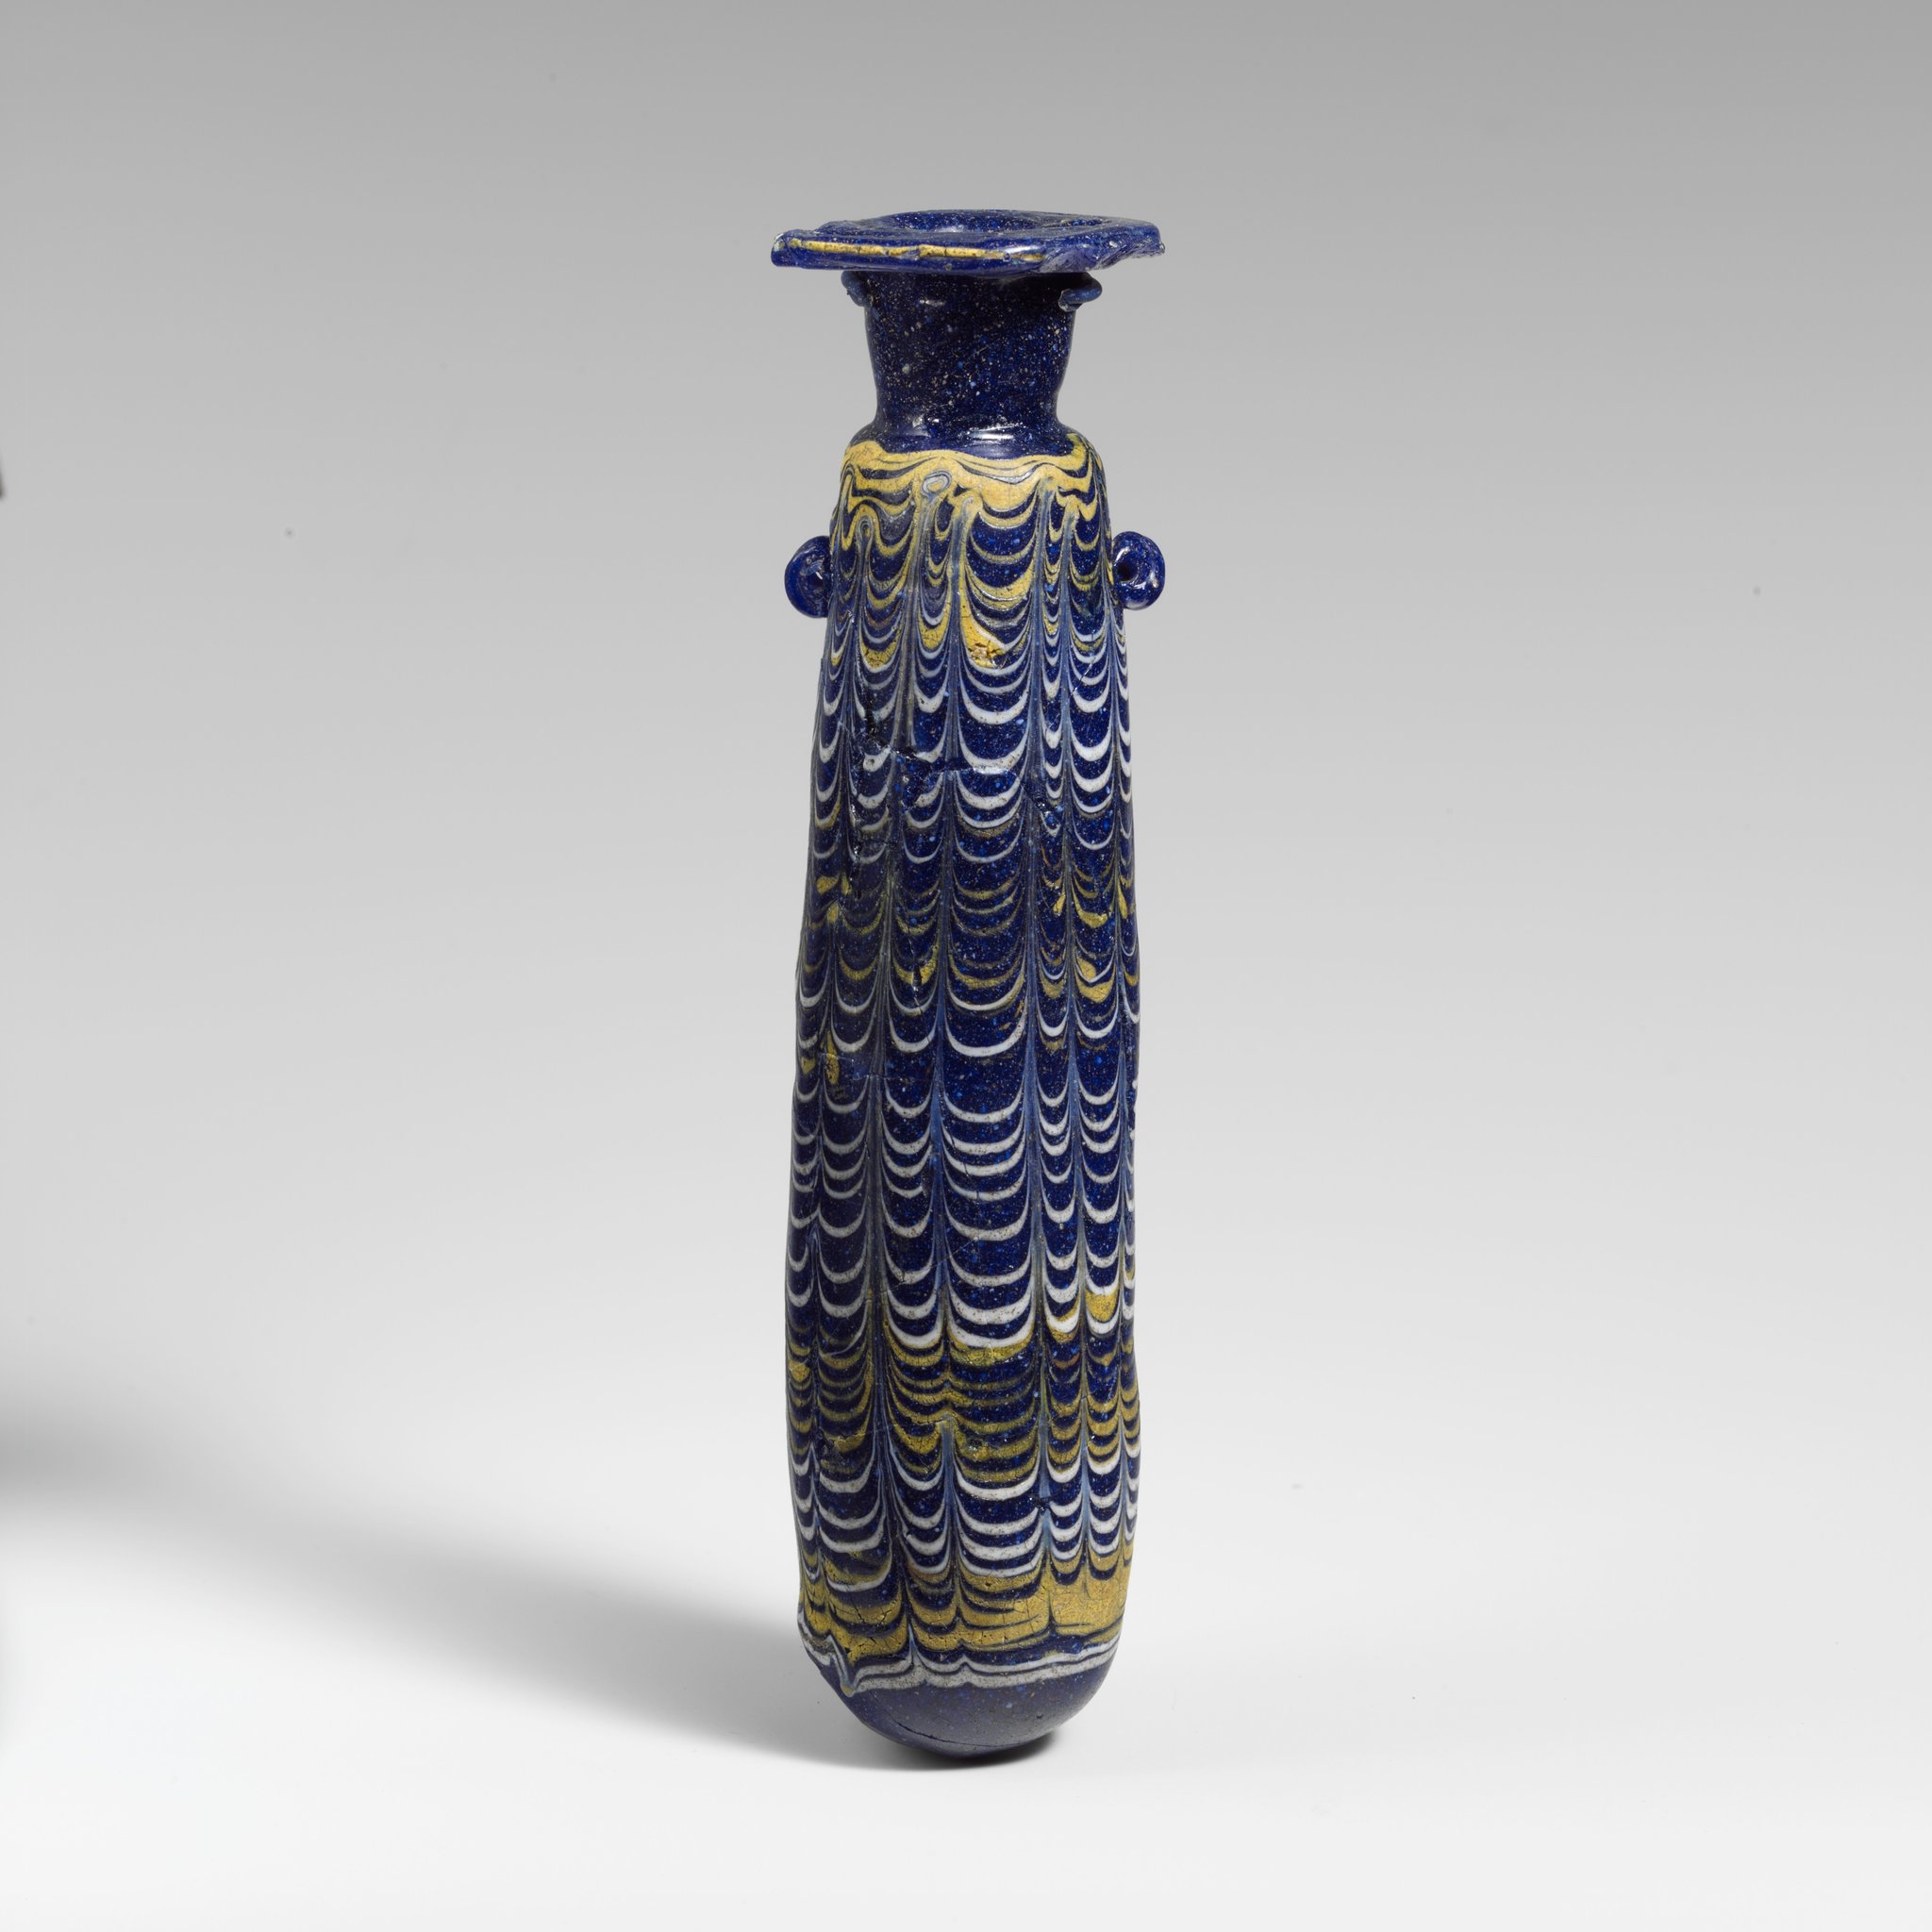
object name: alabastron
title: Glass alabastron (perfume bottle)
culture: eastern mediterranean or italian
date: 334-268 BCE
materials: glass